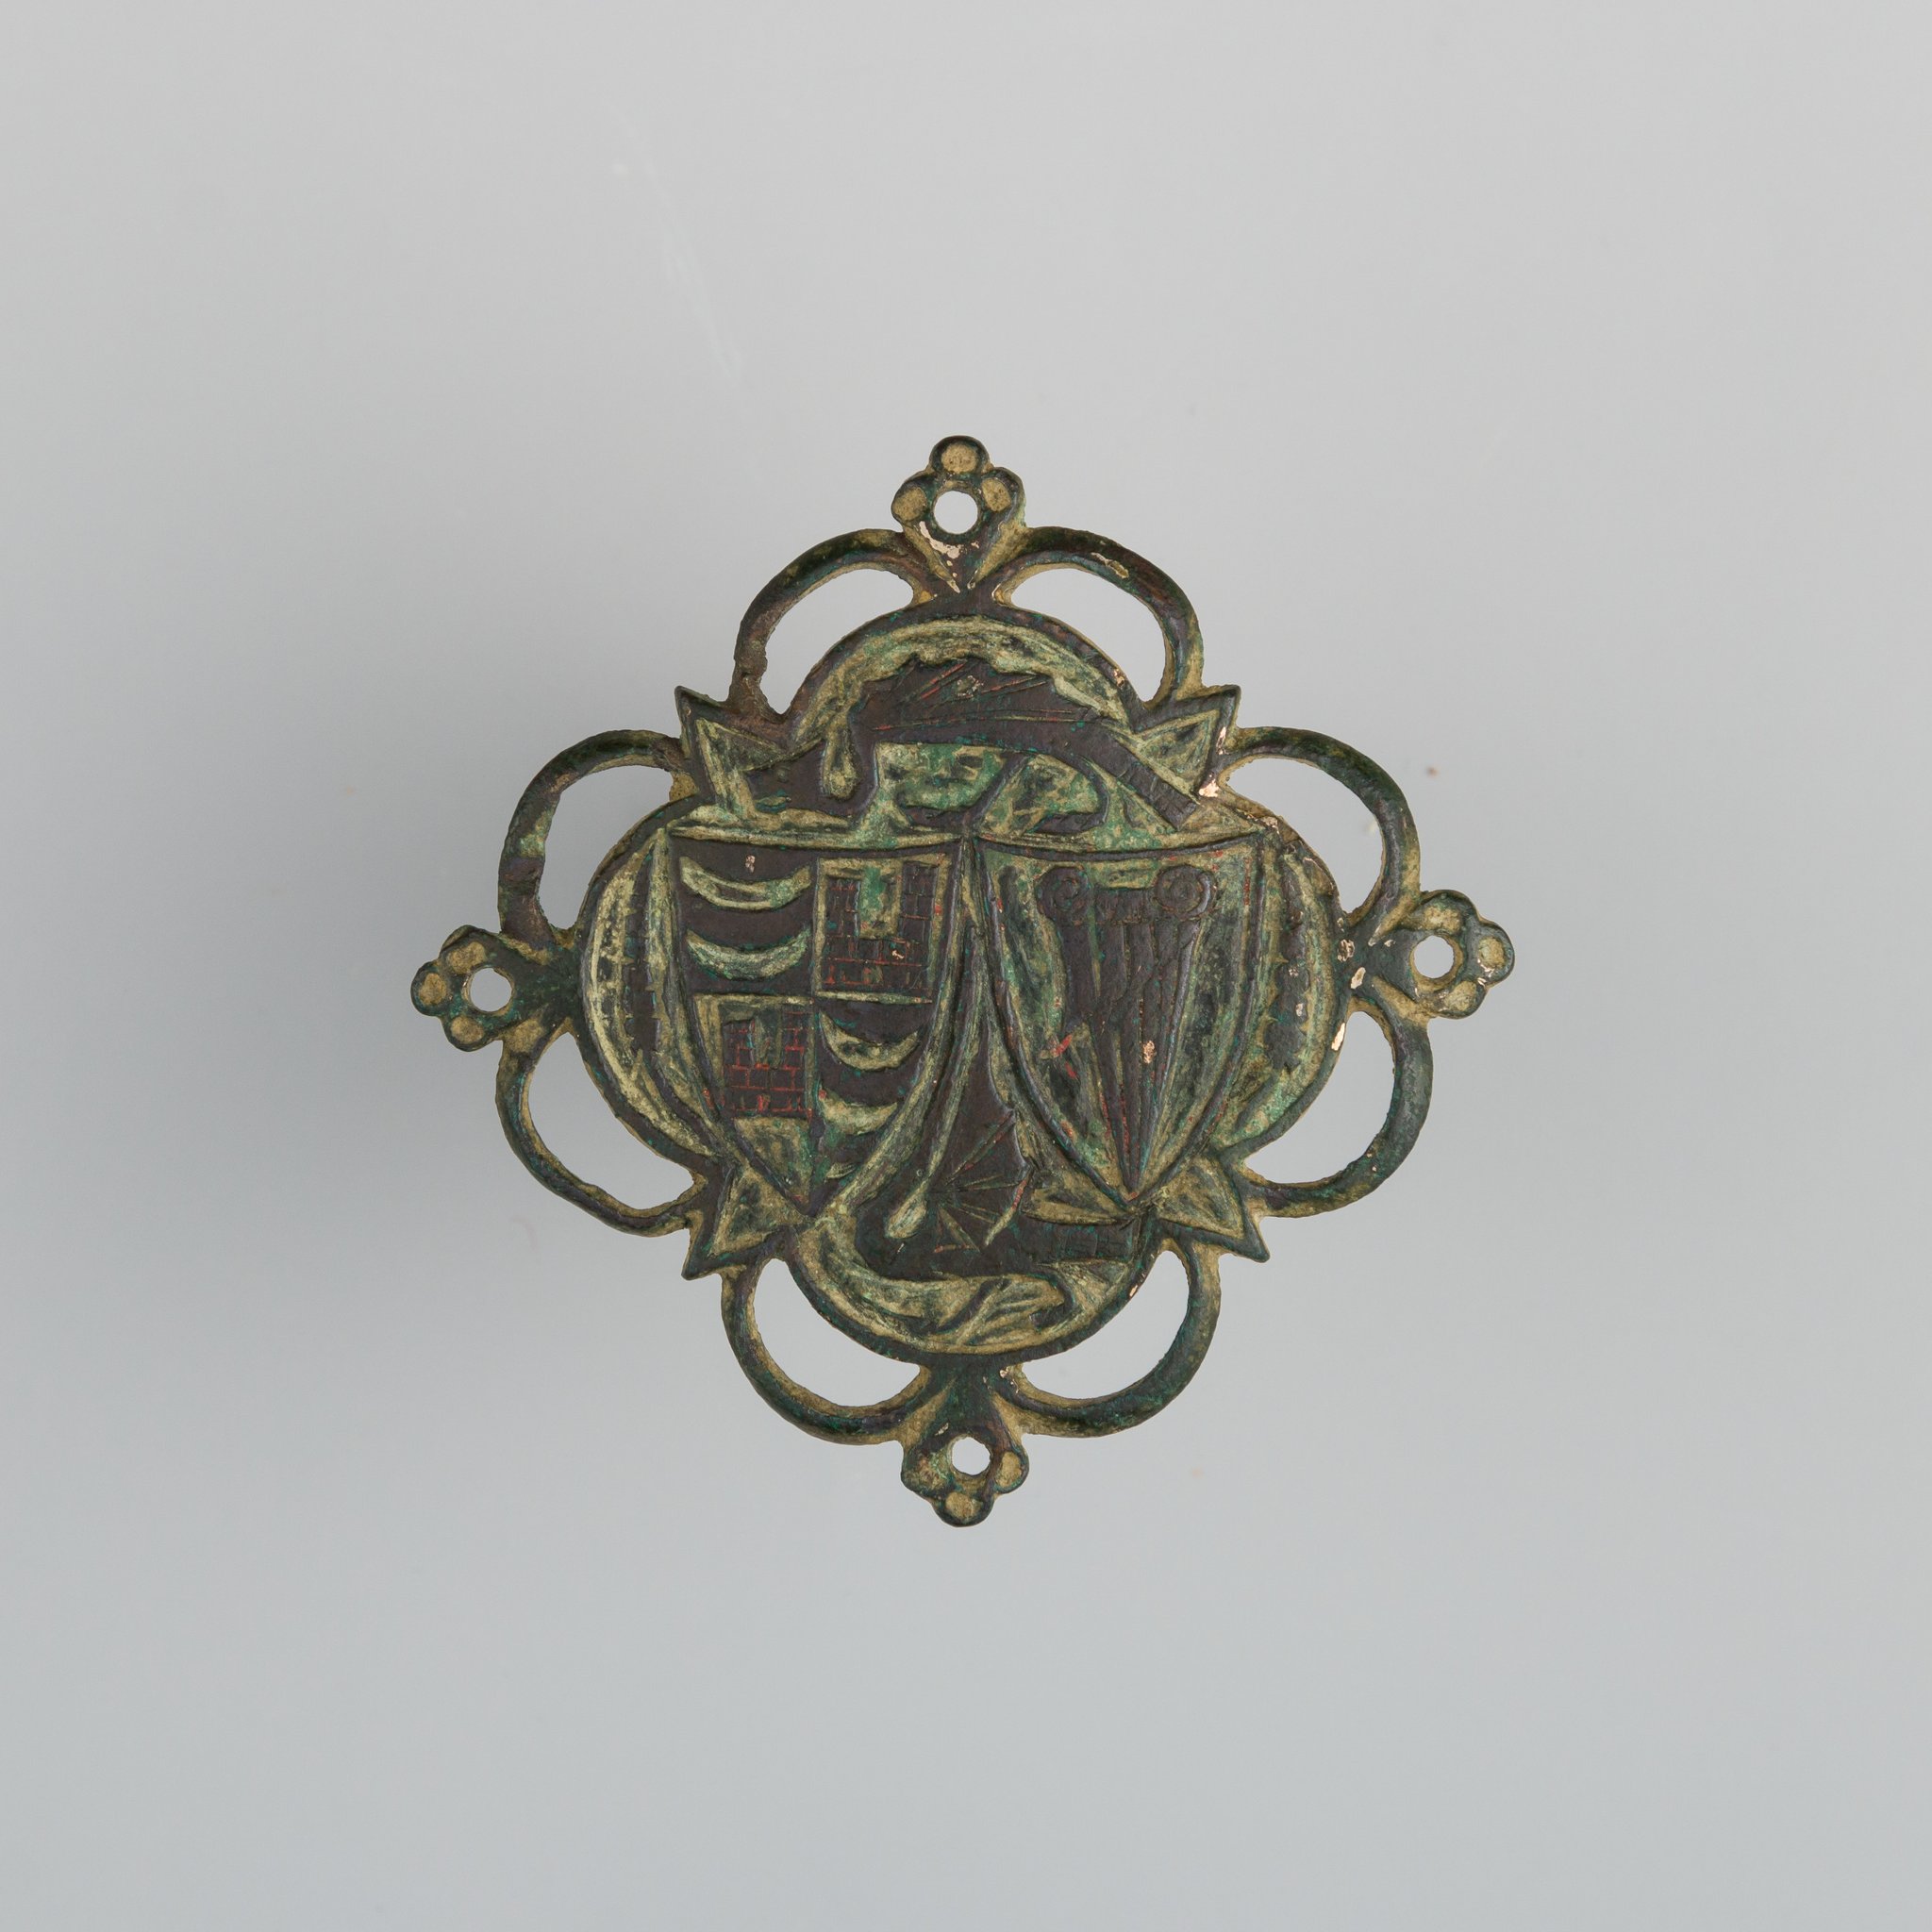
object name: badge or harness pendant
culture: spanish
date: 1401-1500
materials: copper, enamel, gold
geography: spain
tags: coat of arms